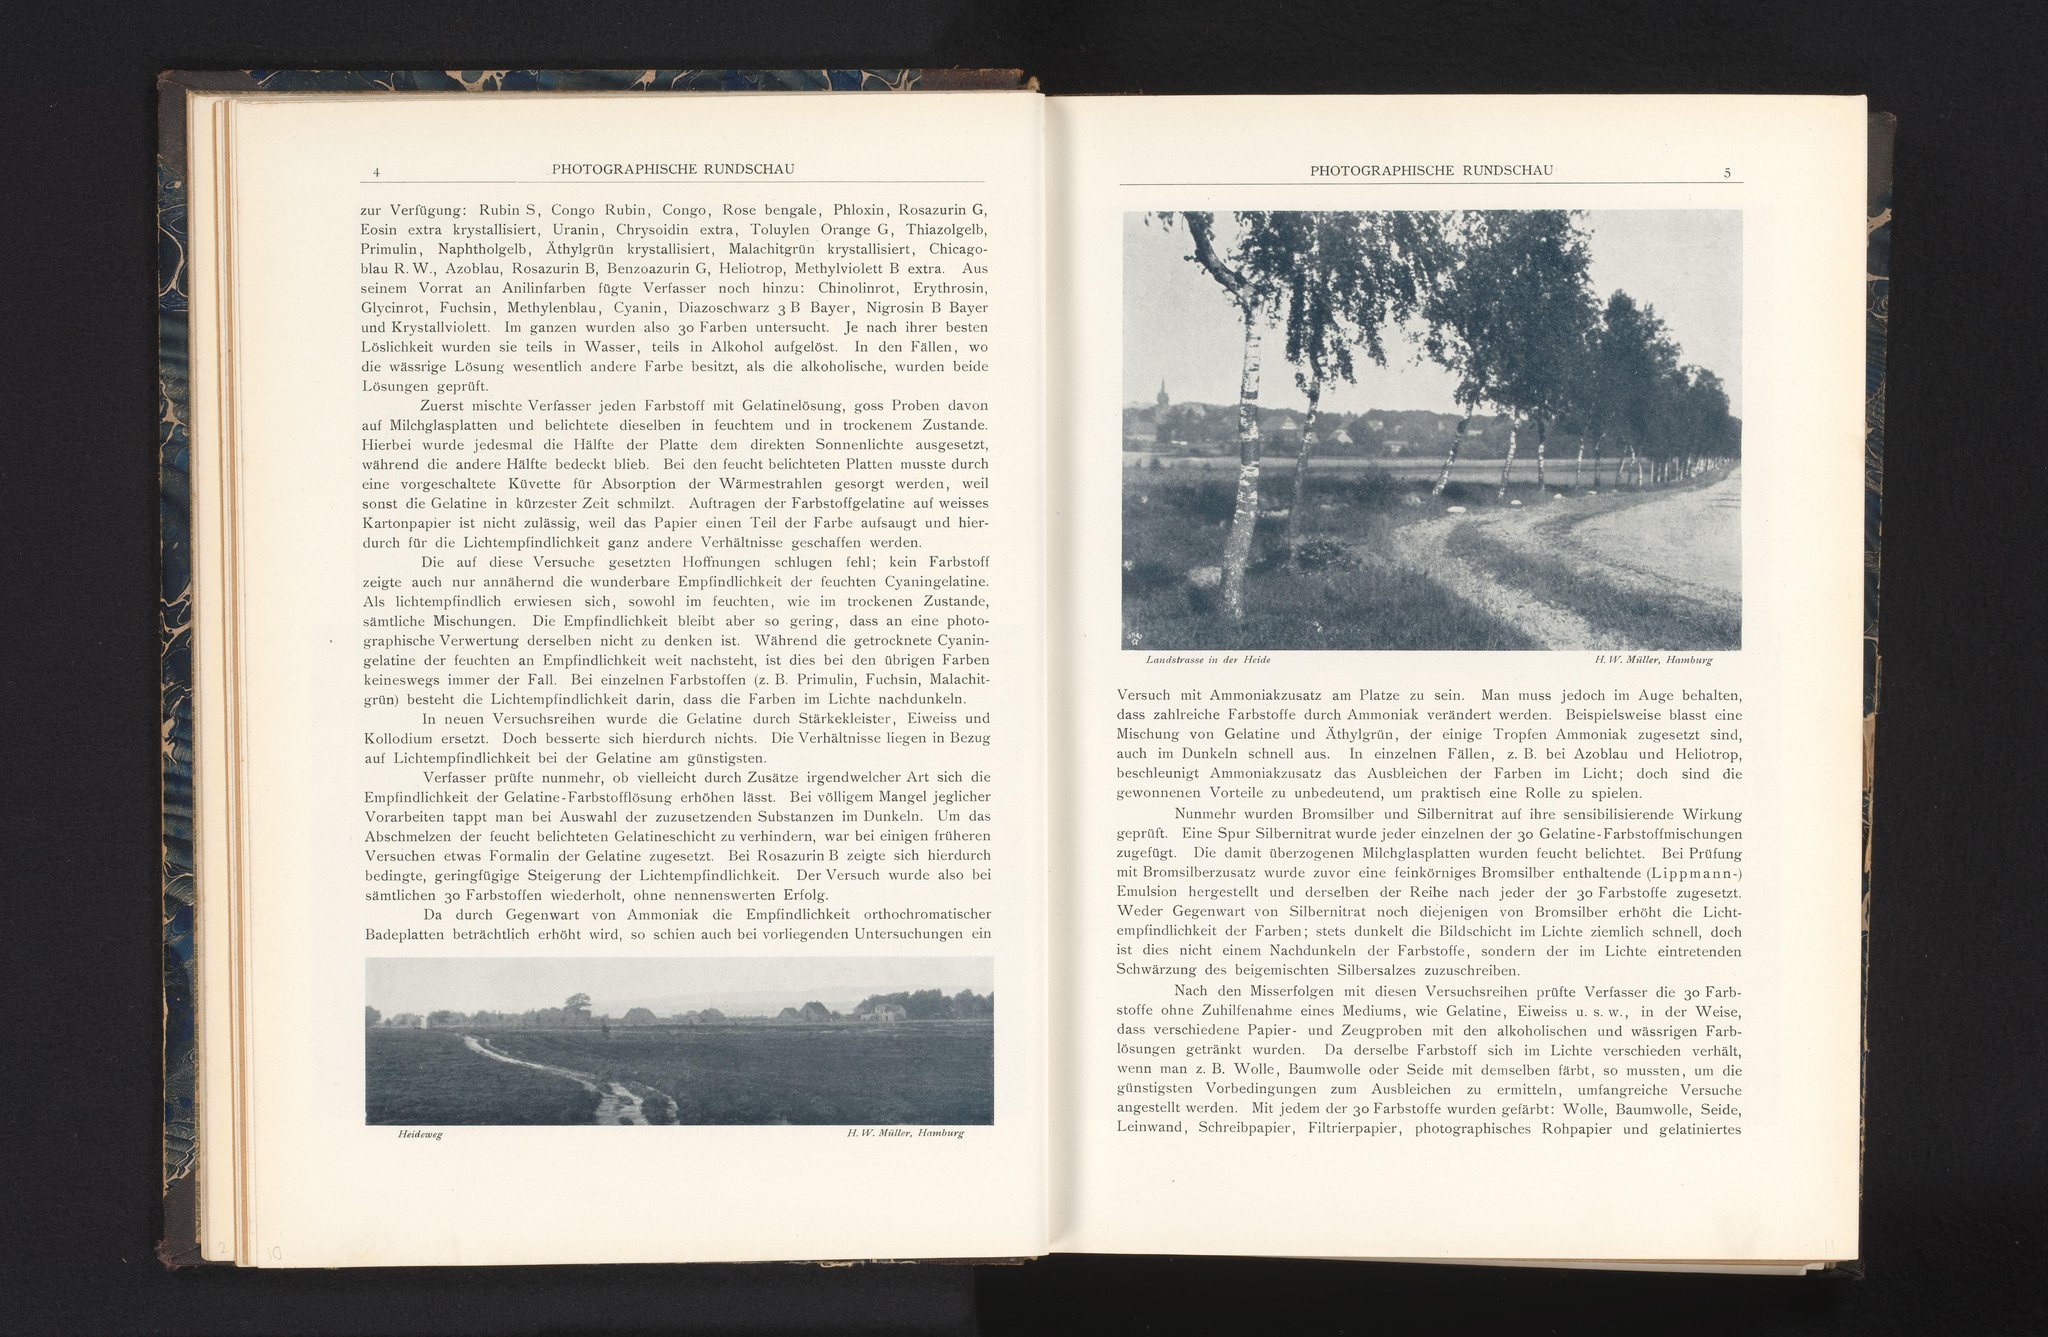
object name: photomechanical print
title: Heideweg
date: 1897-1902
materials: paper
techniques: autotype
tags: meadow, pasture, road, path